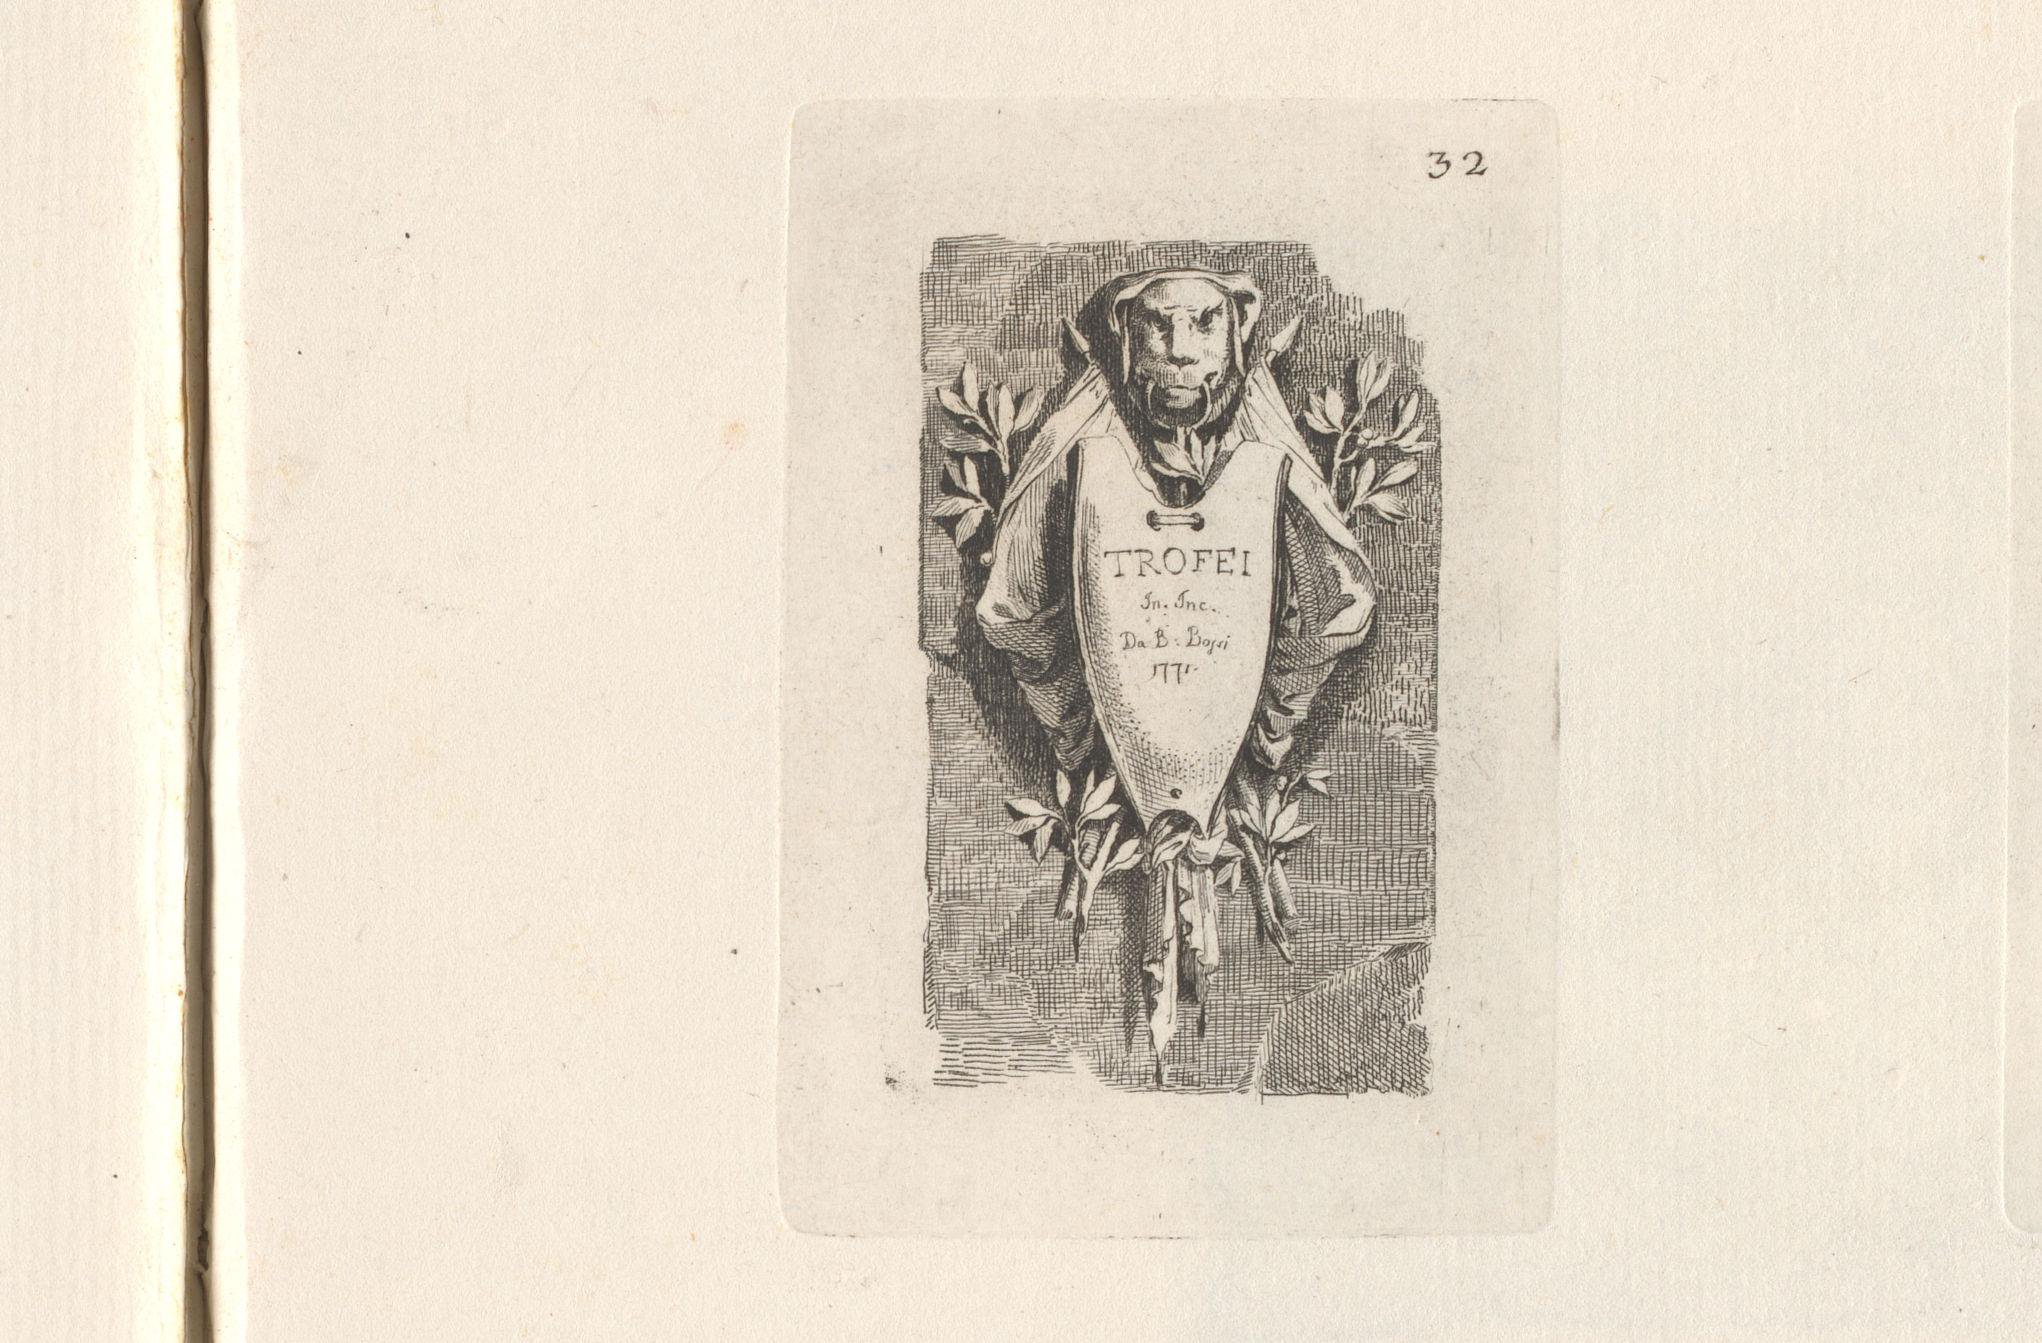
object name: album leaf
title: Raccolta di teste, pensieri, trofei e prove varie d'acquaforte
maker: benigno bossi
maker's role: print maker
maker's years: 1727-1792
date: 1771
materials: paper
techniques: etching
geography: parma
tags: trophy, i.e.: decorative arrangement of symbolic or typical objects ~ ornament